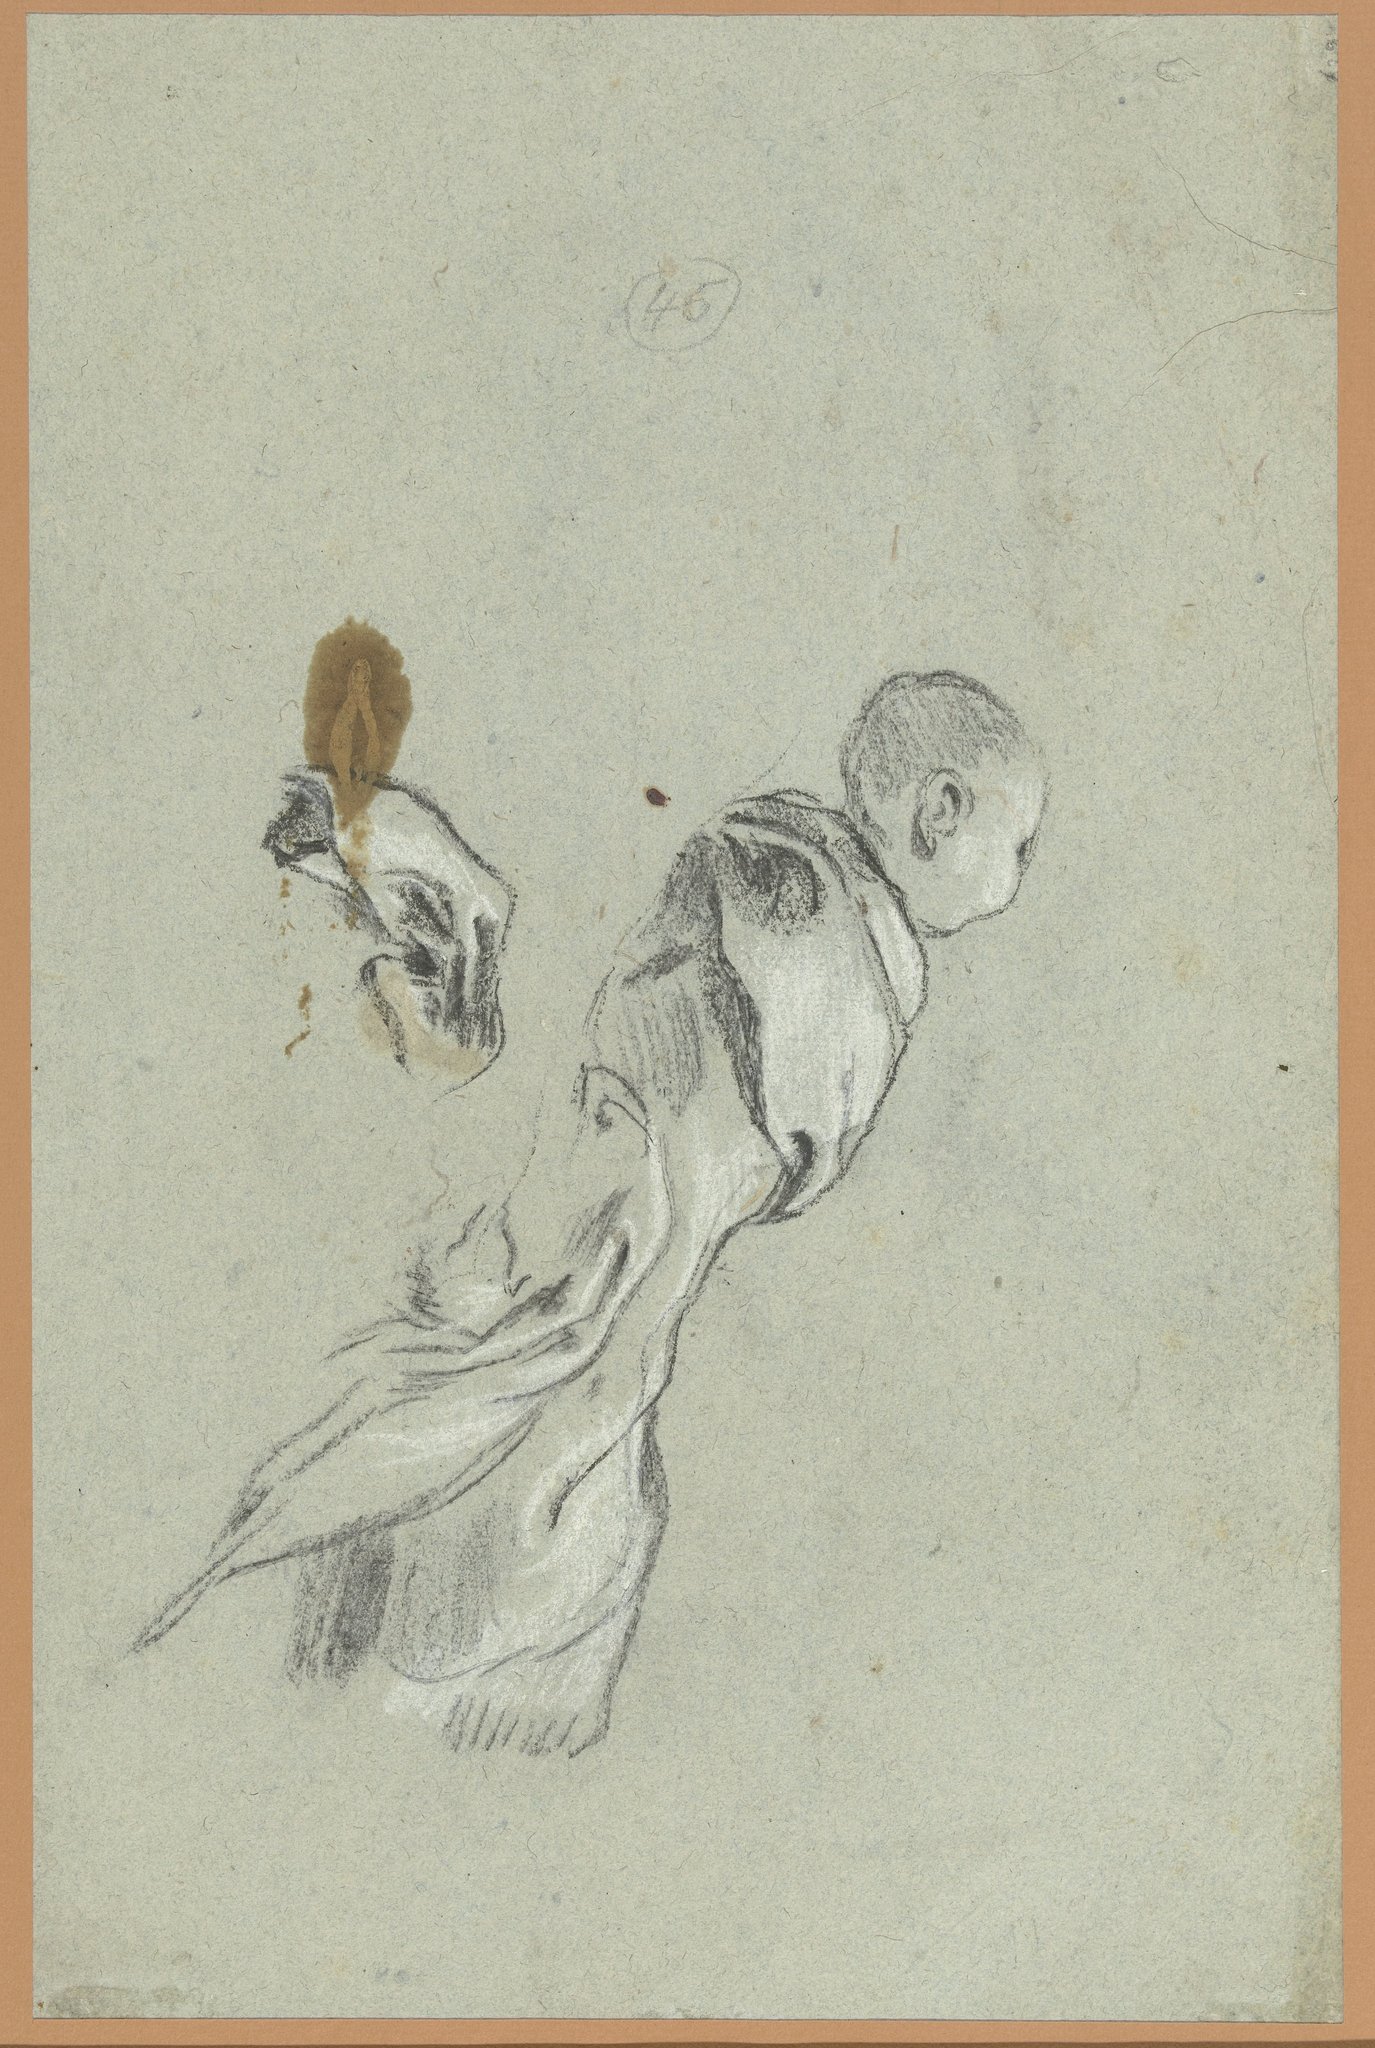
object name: drawing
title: Studie van een in een deken gewikkeld kind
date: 1588-1660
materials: chalk, paper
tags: child, drapery, draped garment, 'gewandgebung'